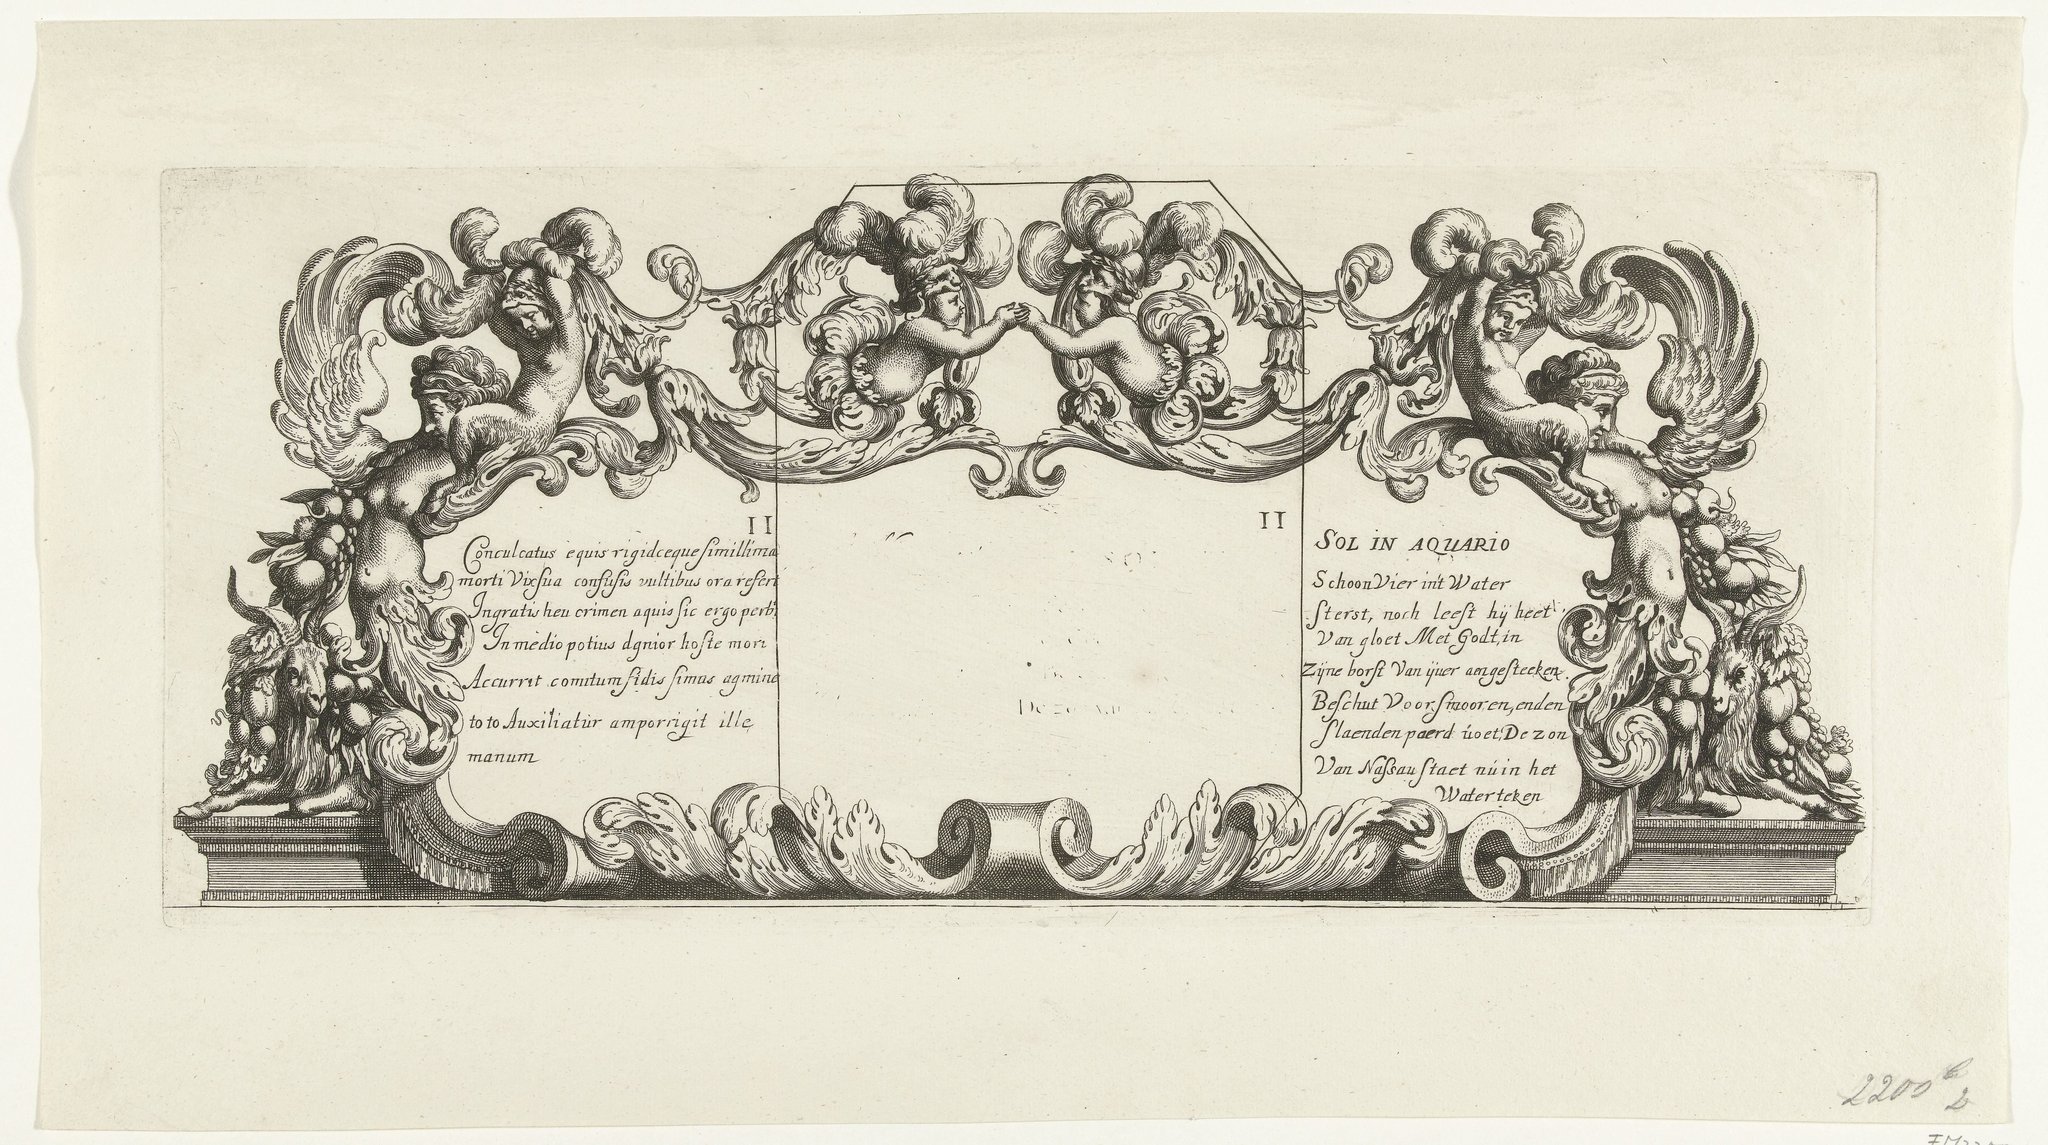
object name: print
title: II Sol in aquario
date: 1665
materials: paper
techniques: etching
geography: northern netherlands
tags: earl, johan maurits graaf van nassau-siegen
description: Blad met een cartouche met twee teksten behorend bij de tweede plaat met de voorstelling van de redding van graaf Johan Maurits op de brug van Franeker, 6 januari 1665. Cartouche gevormd door putti en ranken. Links een vers van zeven regels in het Latijn, rechts een vers van 8 regels in het Nederlands. In het middelste deel van de cartouche heeft een tekst gestaan maar die is weggepolijst.